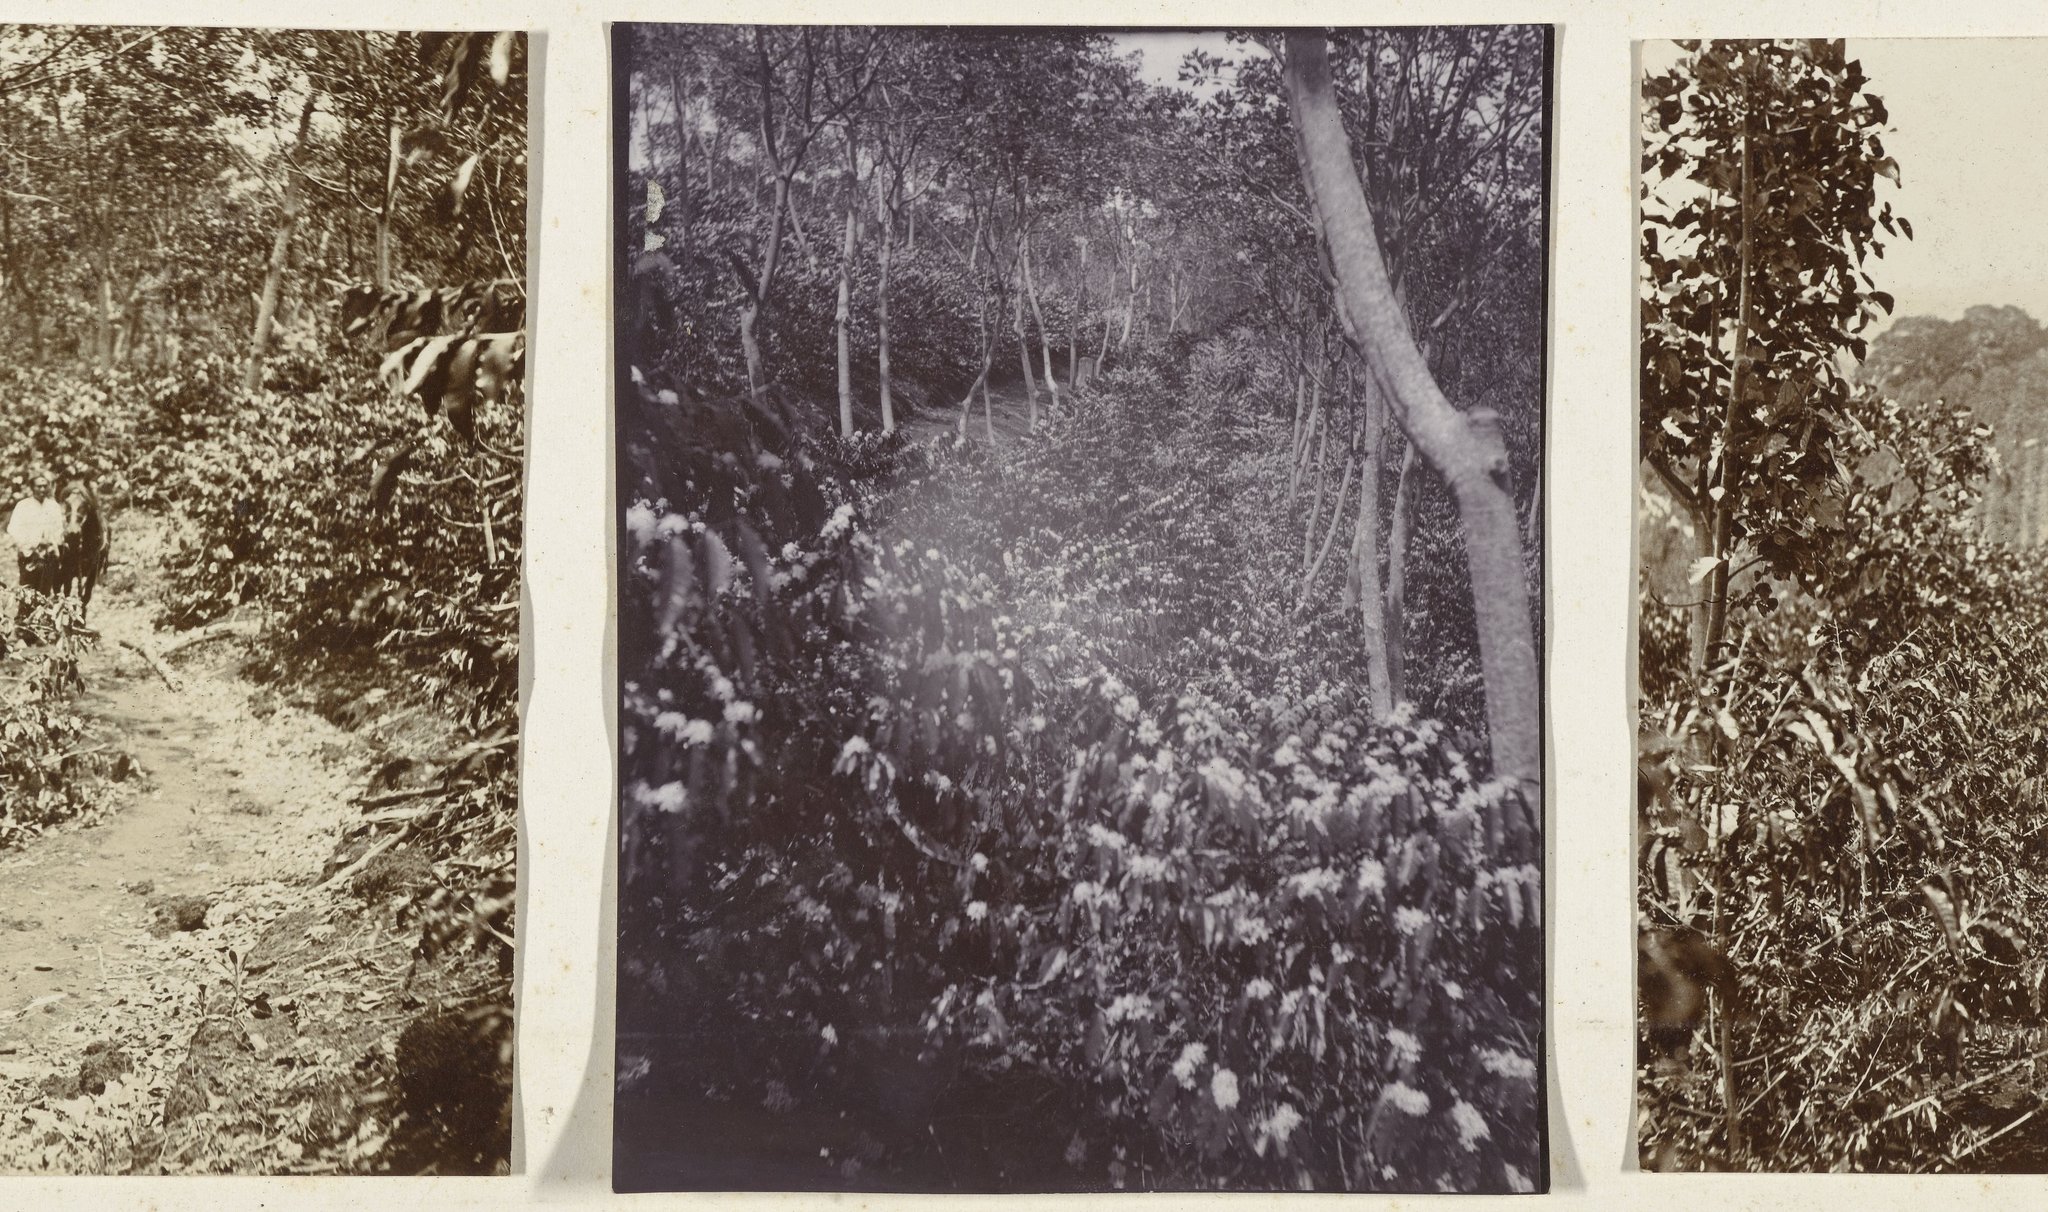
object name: photograph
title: Bosgezicht nabij de koffieplantage van Silo Sanen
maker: Anonymous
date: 1890-1910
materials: cardboard, paper, photographic support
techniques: gelatin silver print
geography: indonesia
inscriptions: caption: ‘Koffietuinen van Silo Sanen’